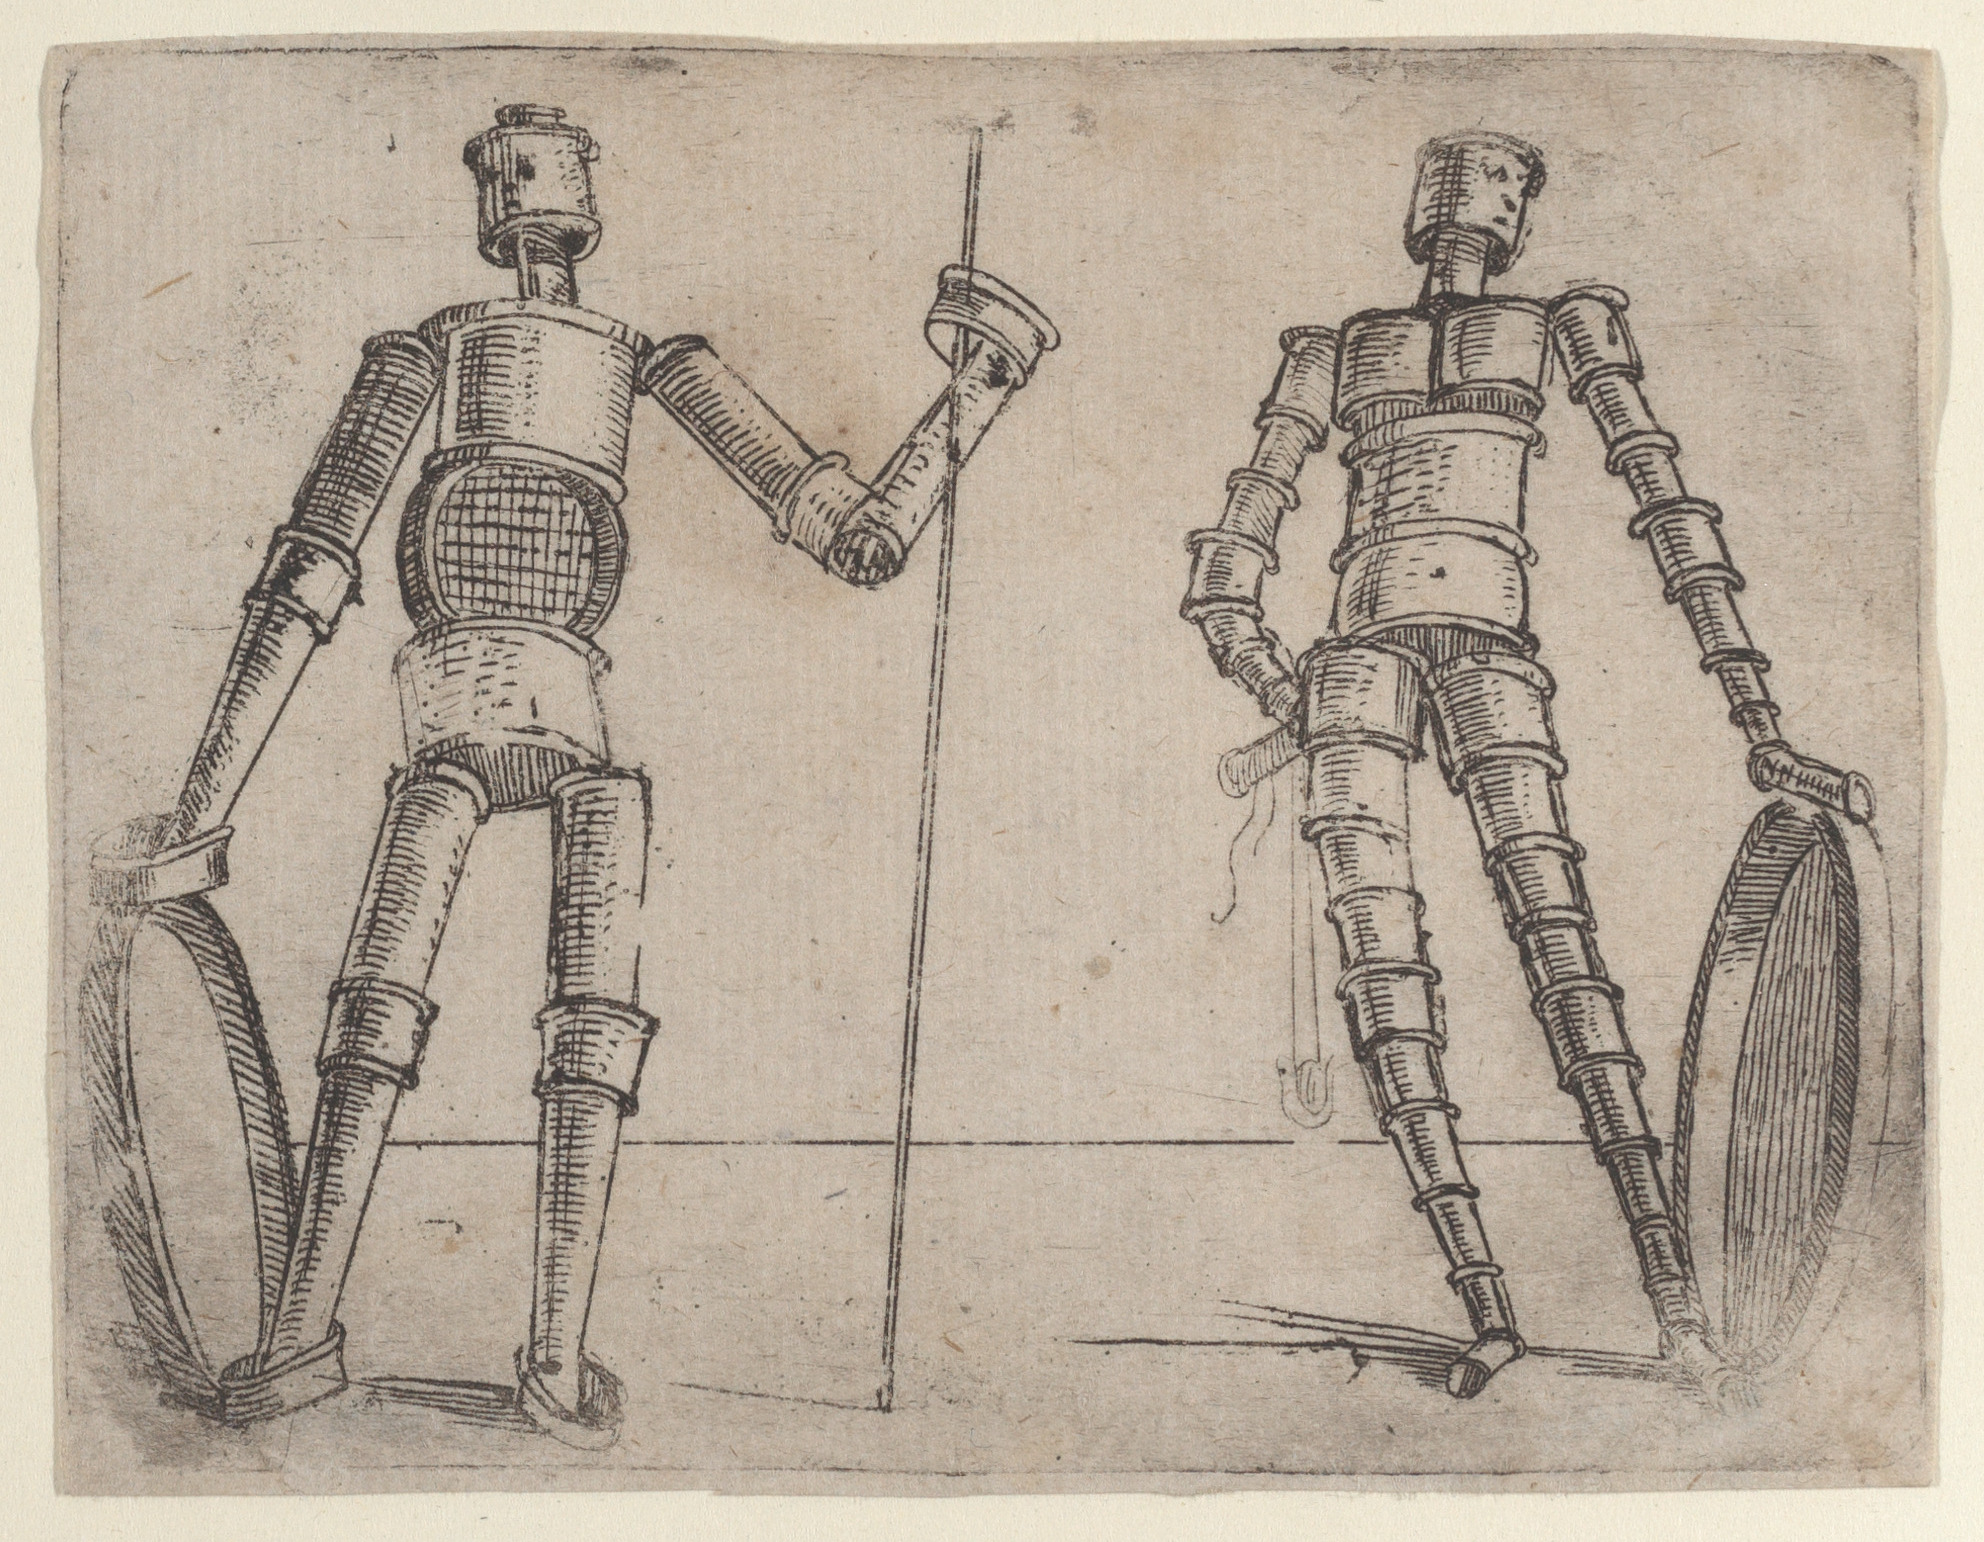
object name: print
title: Plate 20: two figures composed of pipes and sieves from 'Bizzarie di varie figure'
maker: giovanni battista bracelli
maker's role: artist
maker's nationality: italian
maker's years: 1590-1690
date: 1624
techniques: etching